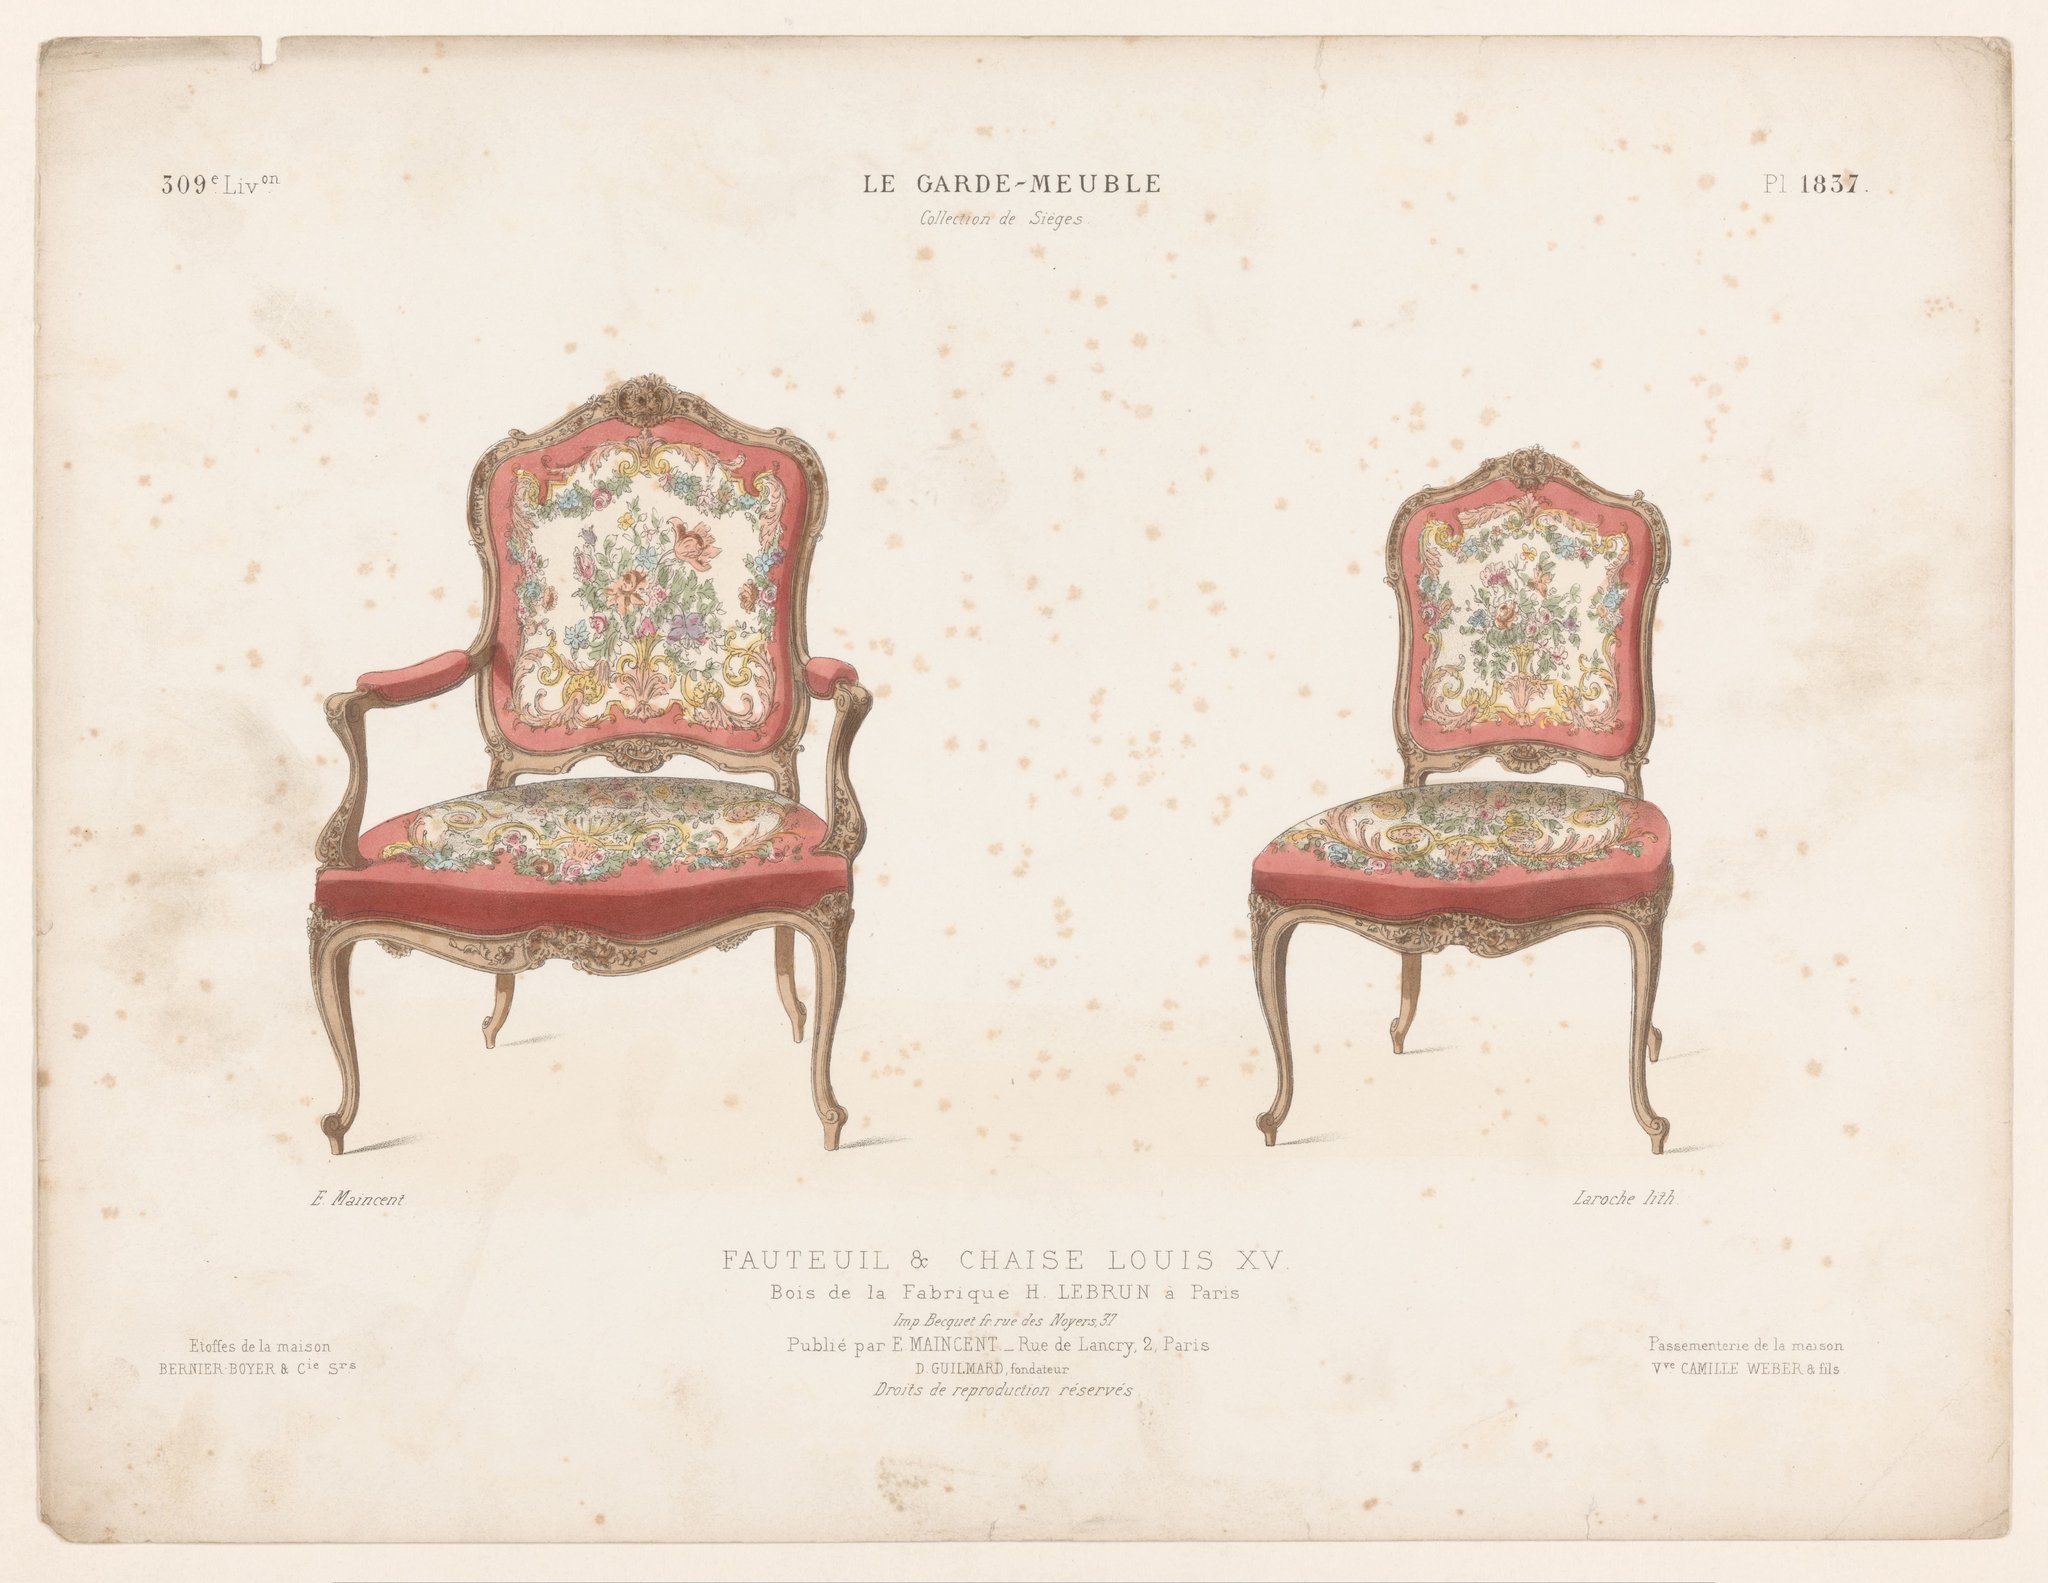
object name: print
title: Fauteuil en stoel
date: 1885-1895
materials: paper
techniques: hand coloring, lithograph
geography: paris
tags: seating furniture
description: Ieder Livraison in de serie Le Garde-Meuble bevat negen platen: drie 'sièges' (zitmeubels), drie 'meubles' (diverse meubels zoals tafels en kasten) en drie 'tentures' (gordijnen en draperieën).